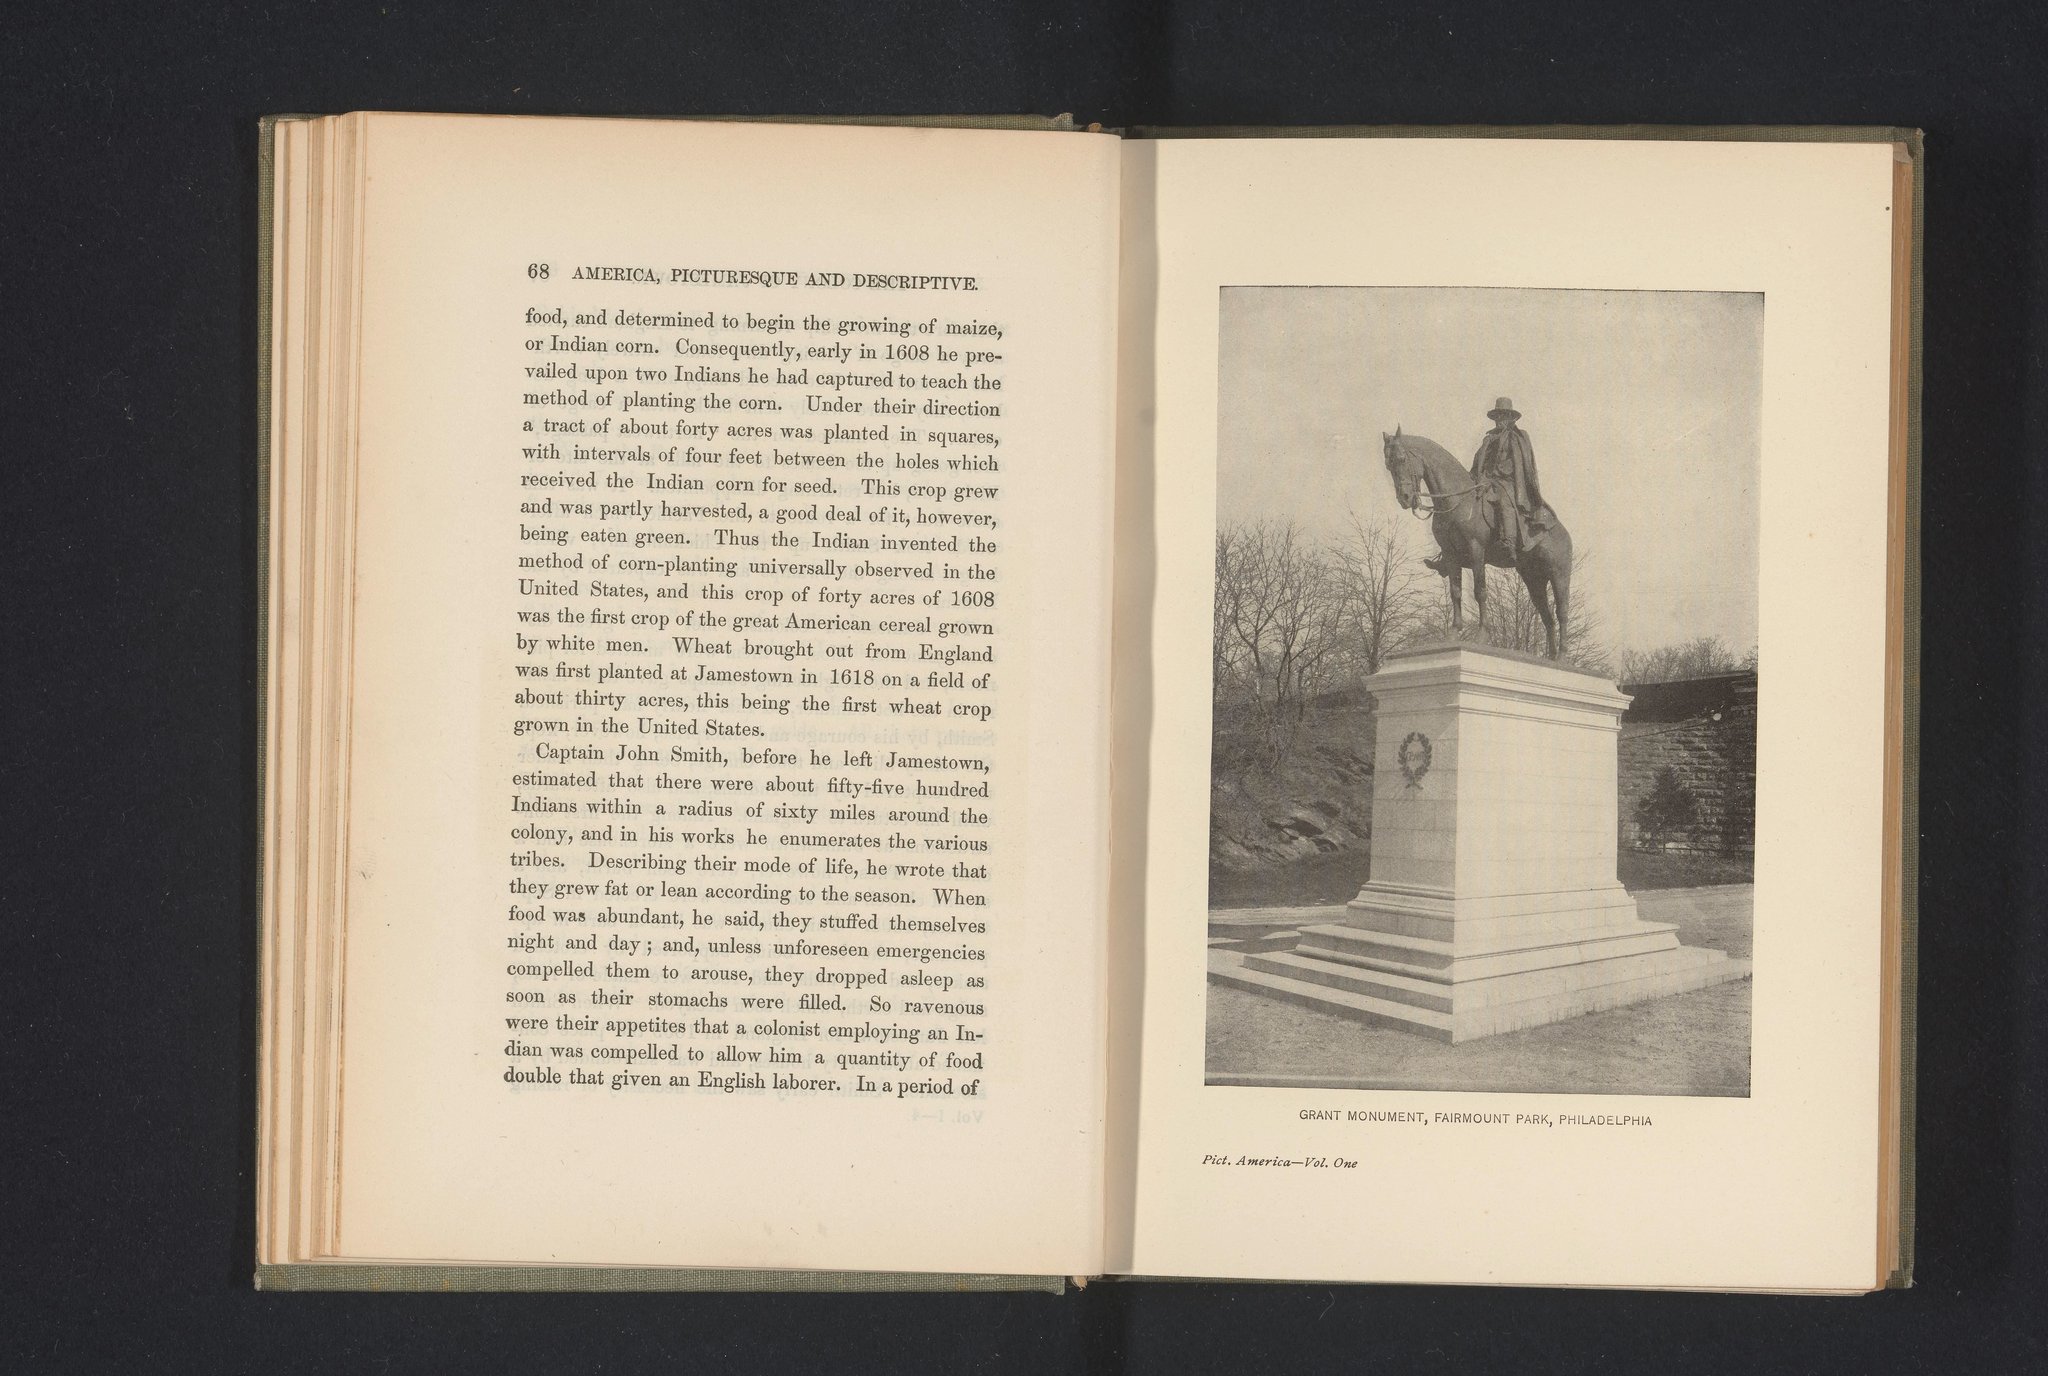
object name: photomechanical print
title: Grant Monument, Fairmount Park, Philadelphia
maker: Anonymous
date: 1890-1900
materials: paper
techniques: autotype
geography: fairmount park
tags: monument, statue, equestrian statue